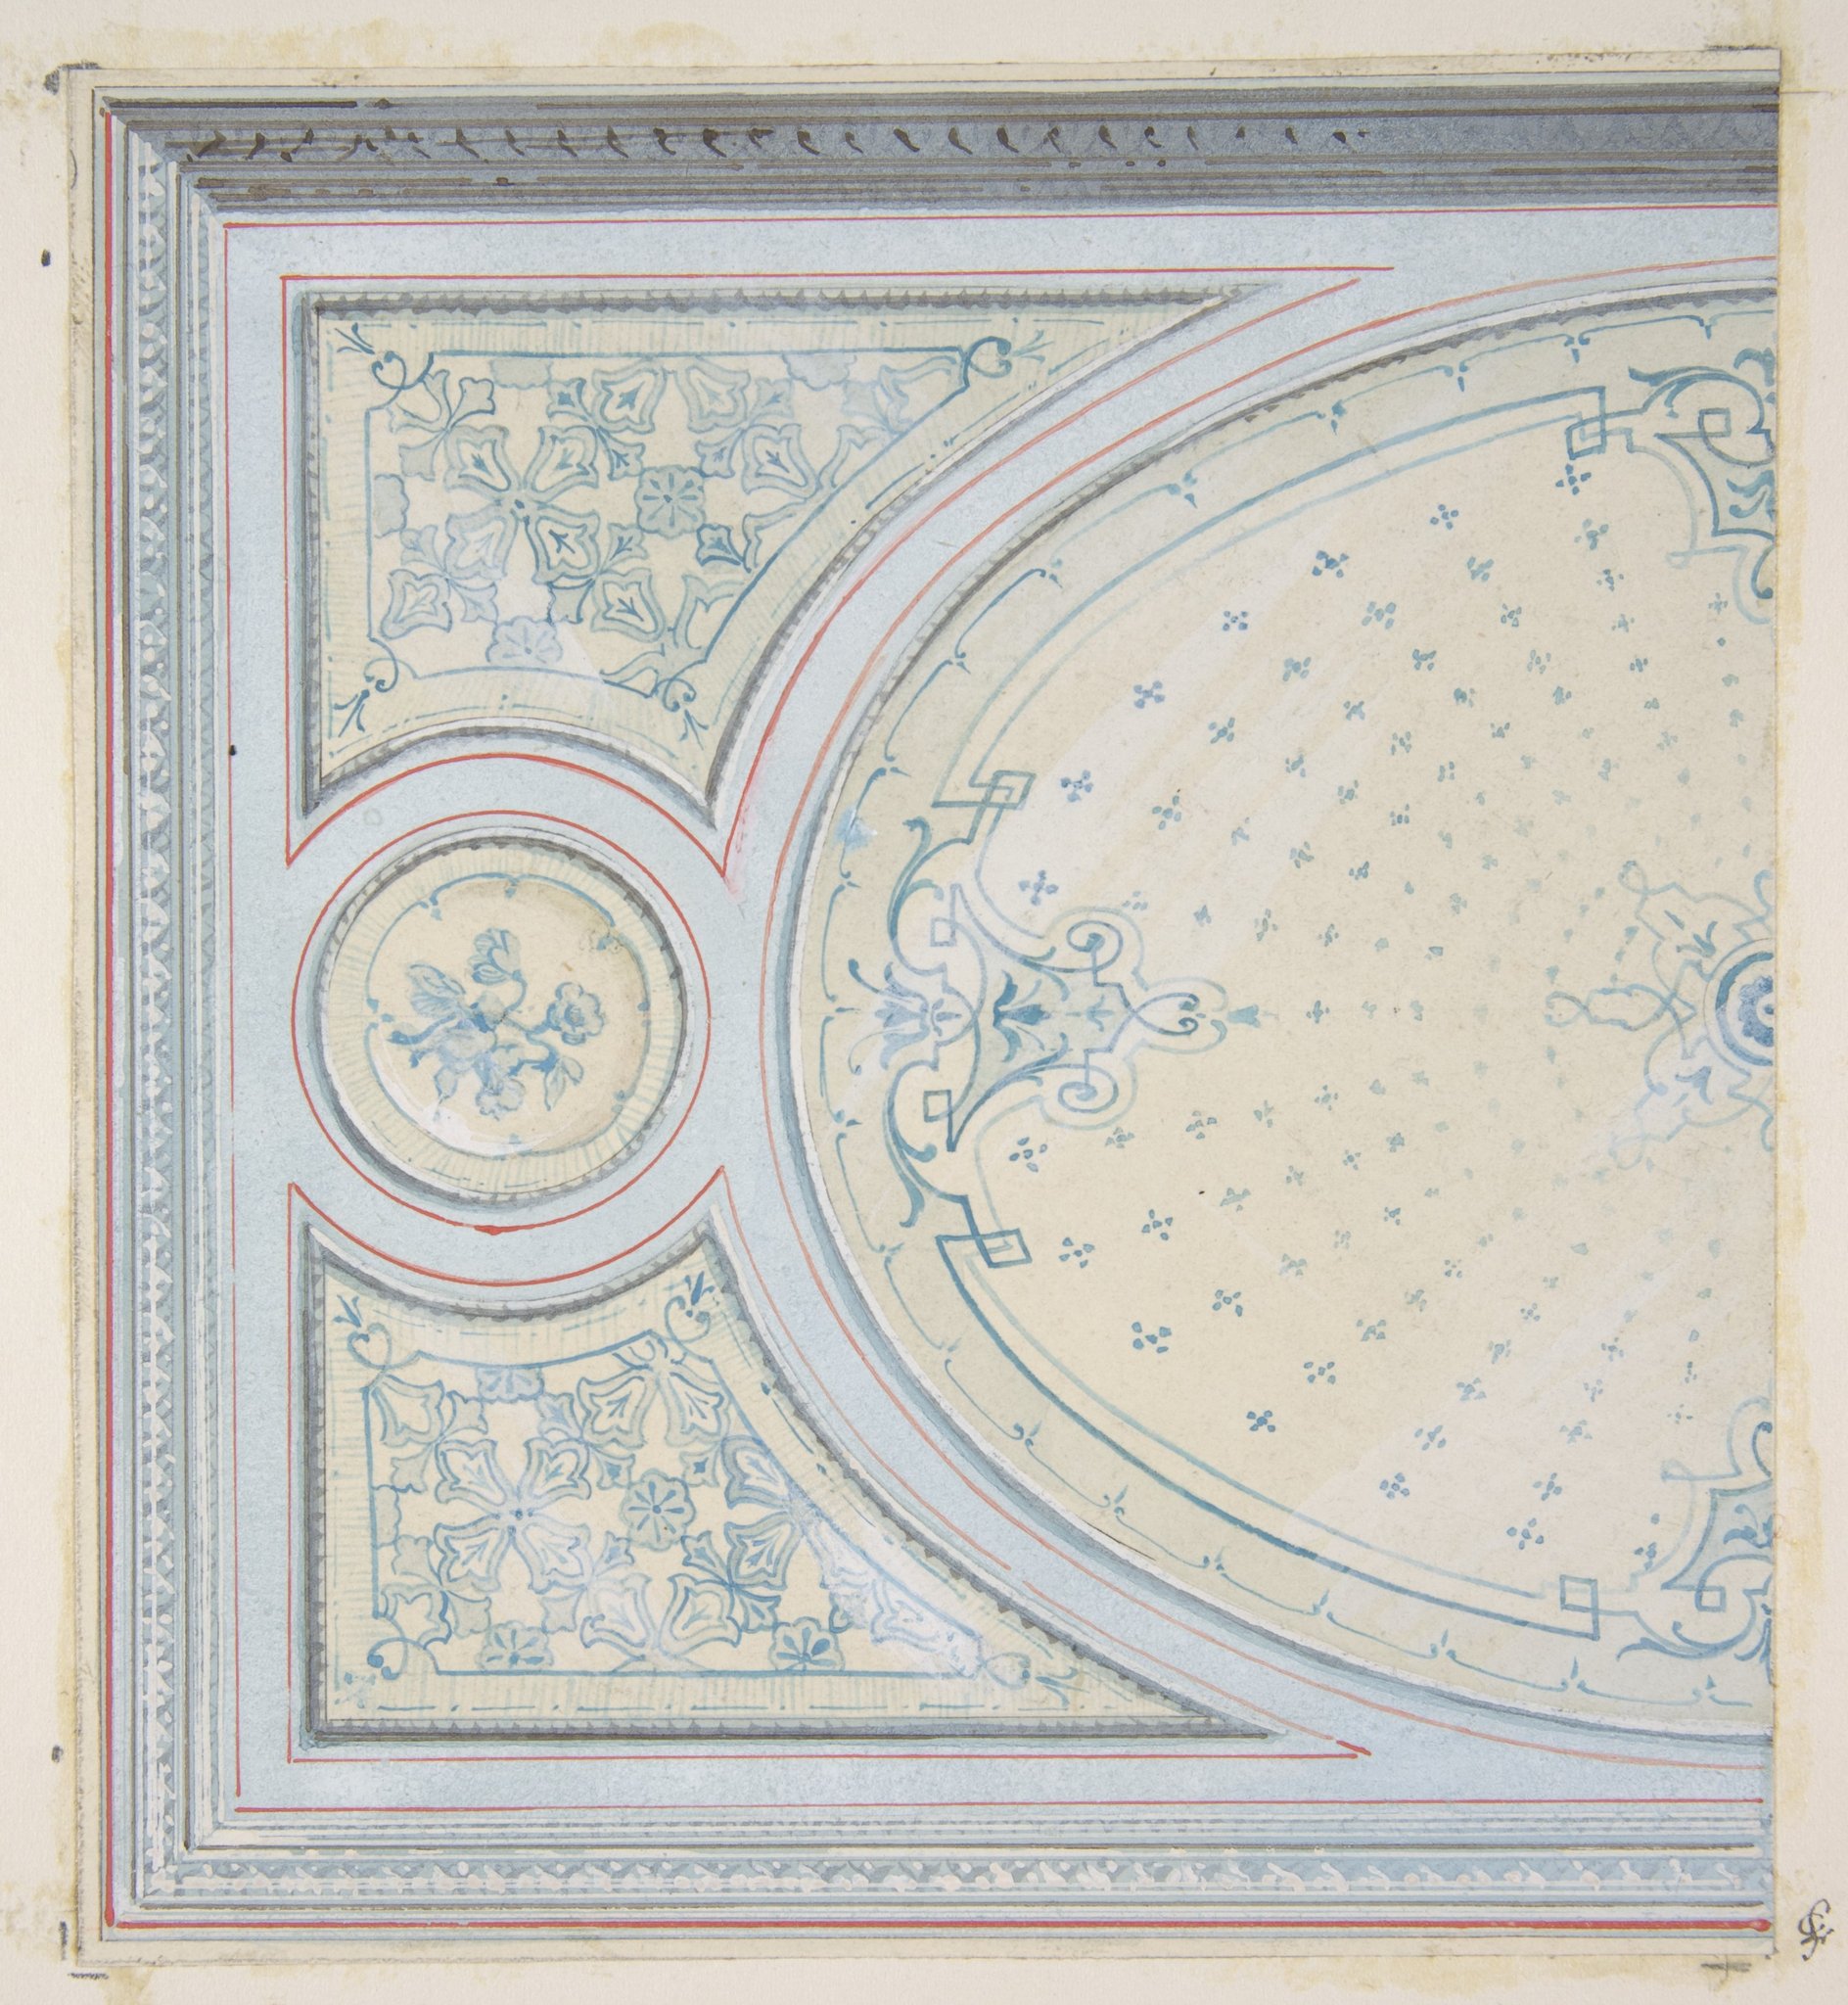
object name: drawing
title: Design for the decoration of a ceiling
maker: jules-edmond-charles lachaise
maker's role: artist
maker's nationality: french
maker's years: 1897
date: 1830-1897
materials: gouache, ink, watercolor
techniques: pen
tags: ceilings